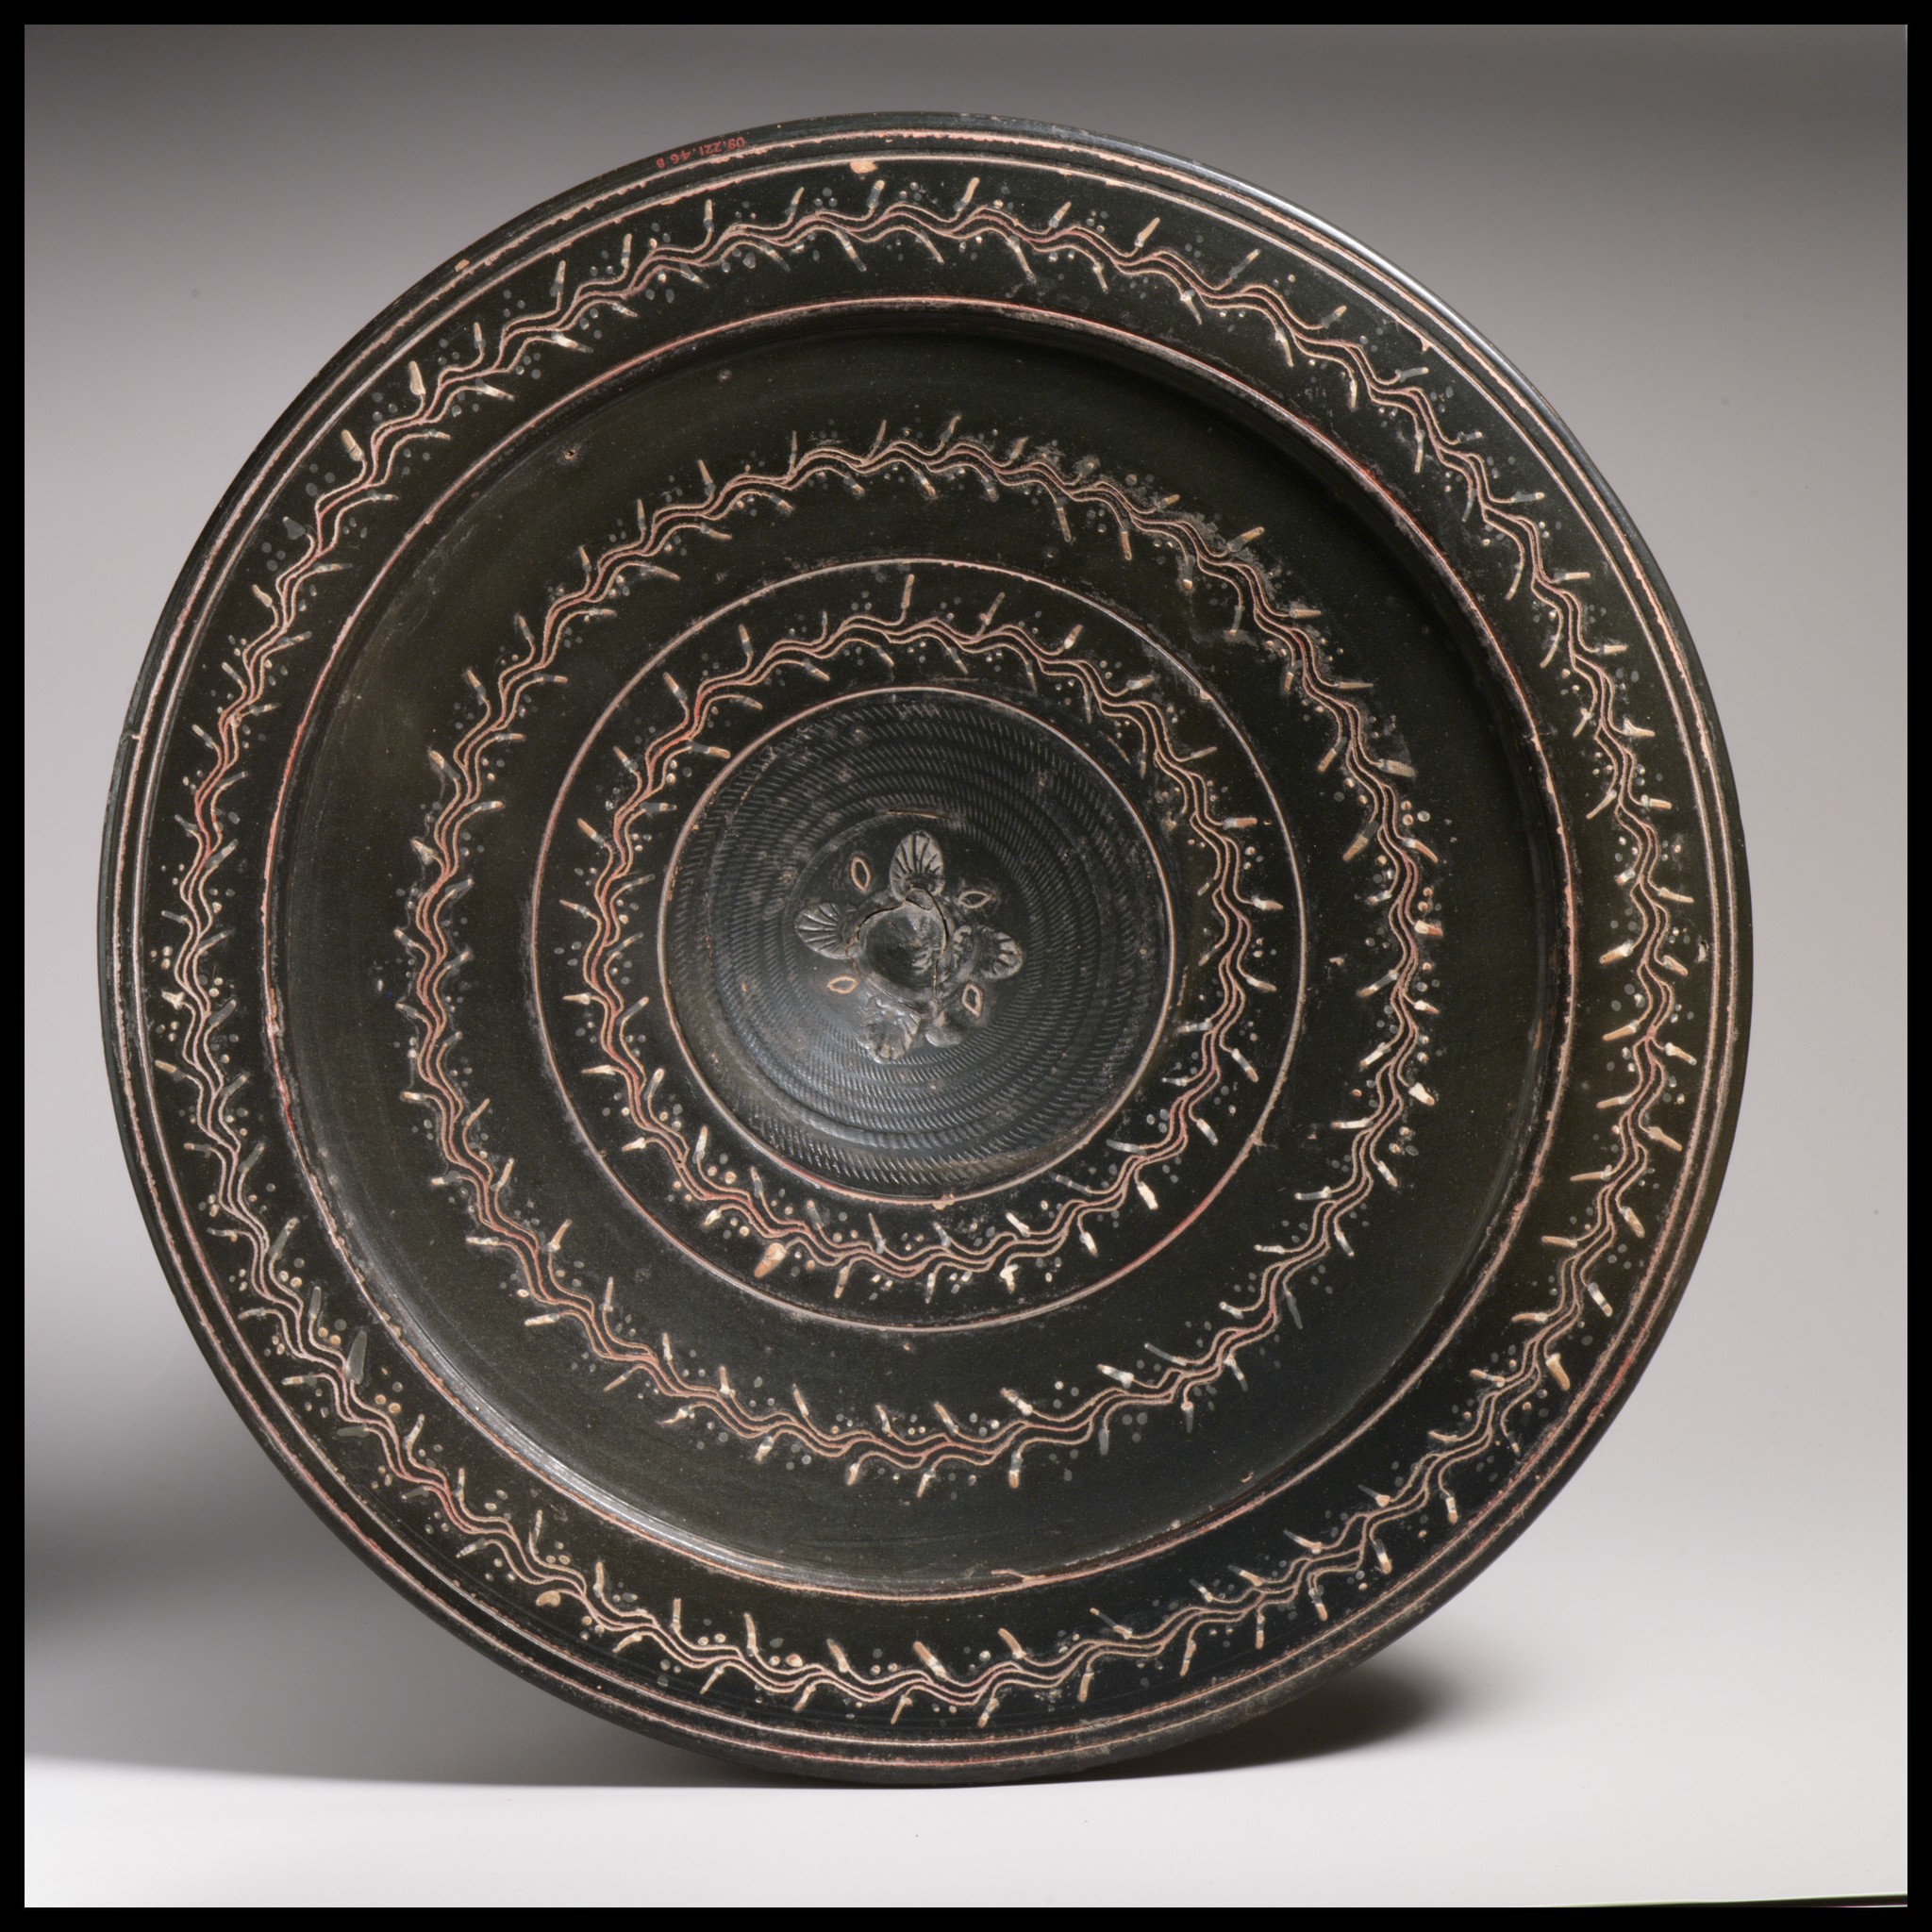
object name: plate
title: Terracotta plate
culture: greek, south italian, campanian, teano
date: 330-300 BCE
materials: terracotta